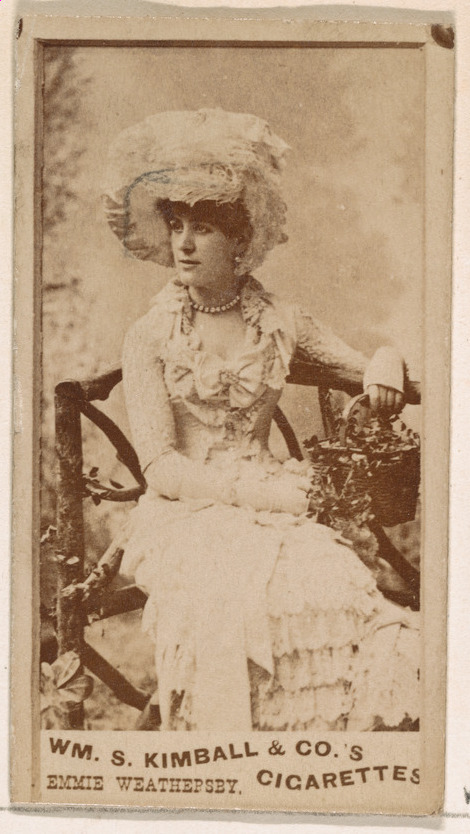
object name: photograph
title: Emmie Weathersby, from the Actresses series (N203) issued by Wm. S. Kimball & Co.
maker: william s. kimball & company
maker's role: publisher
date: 1889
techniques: color lithograph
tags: portraits,women,actresses